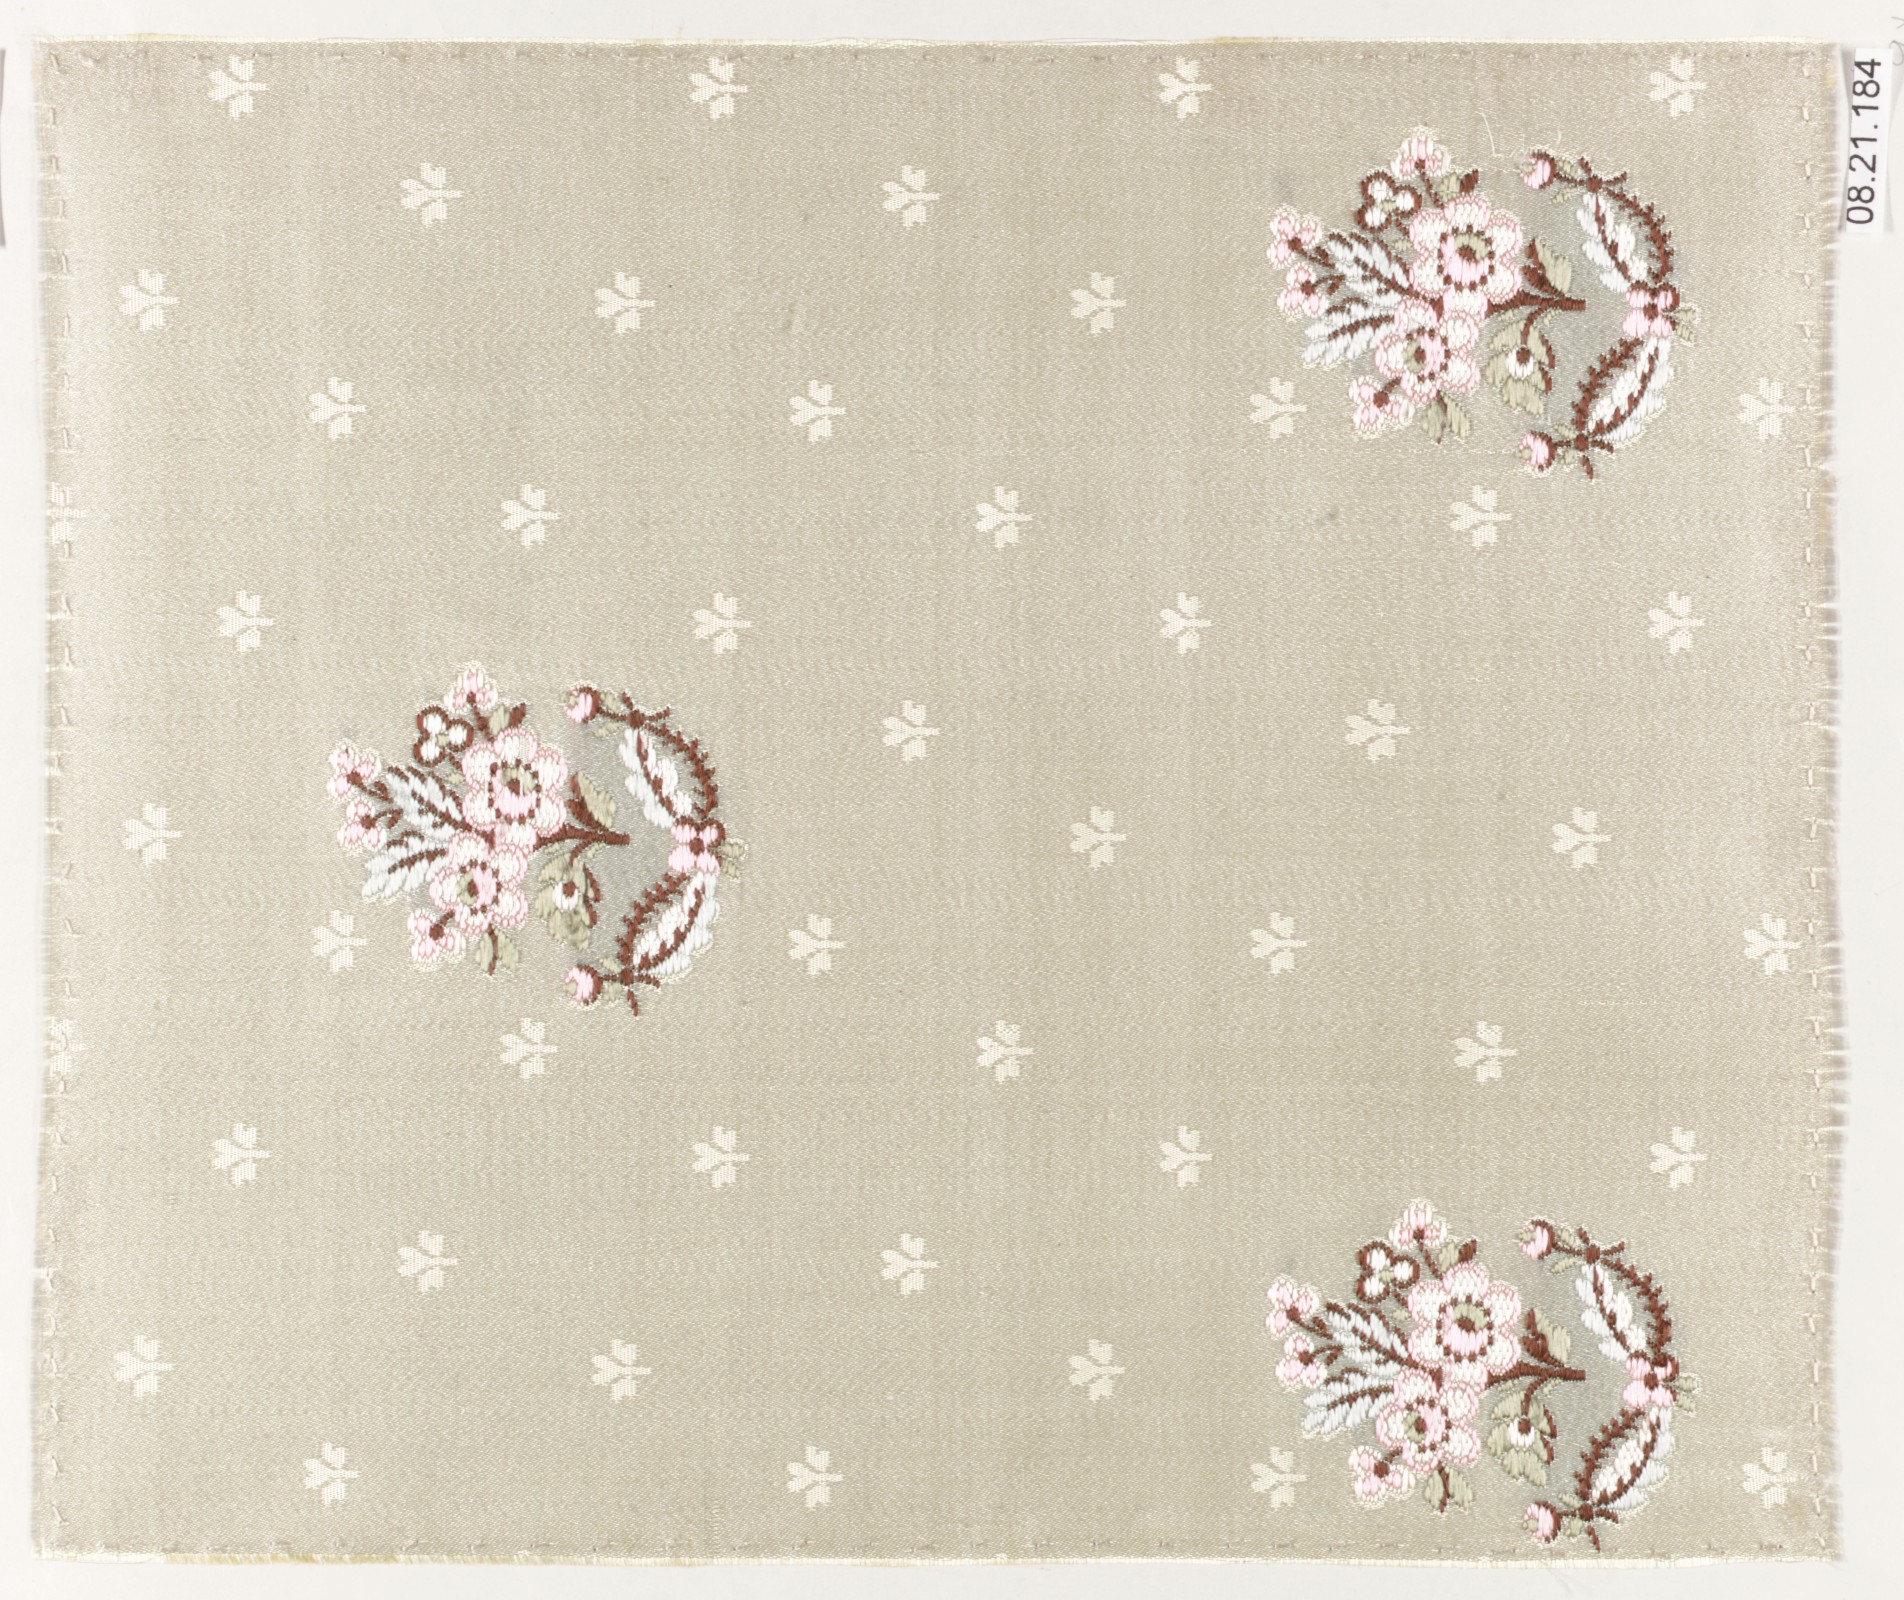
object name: textile sample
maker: Anonymous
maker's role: designer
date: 1900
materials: silk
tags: flowers